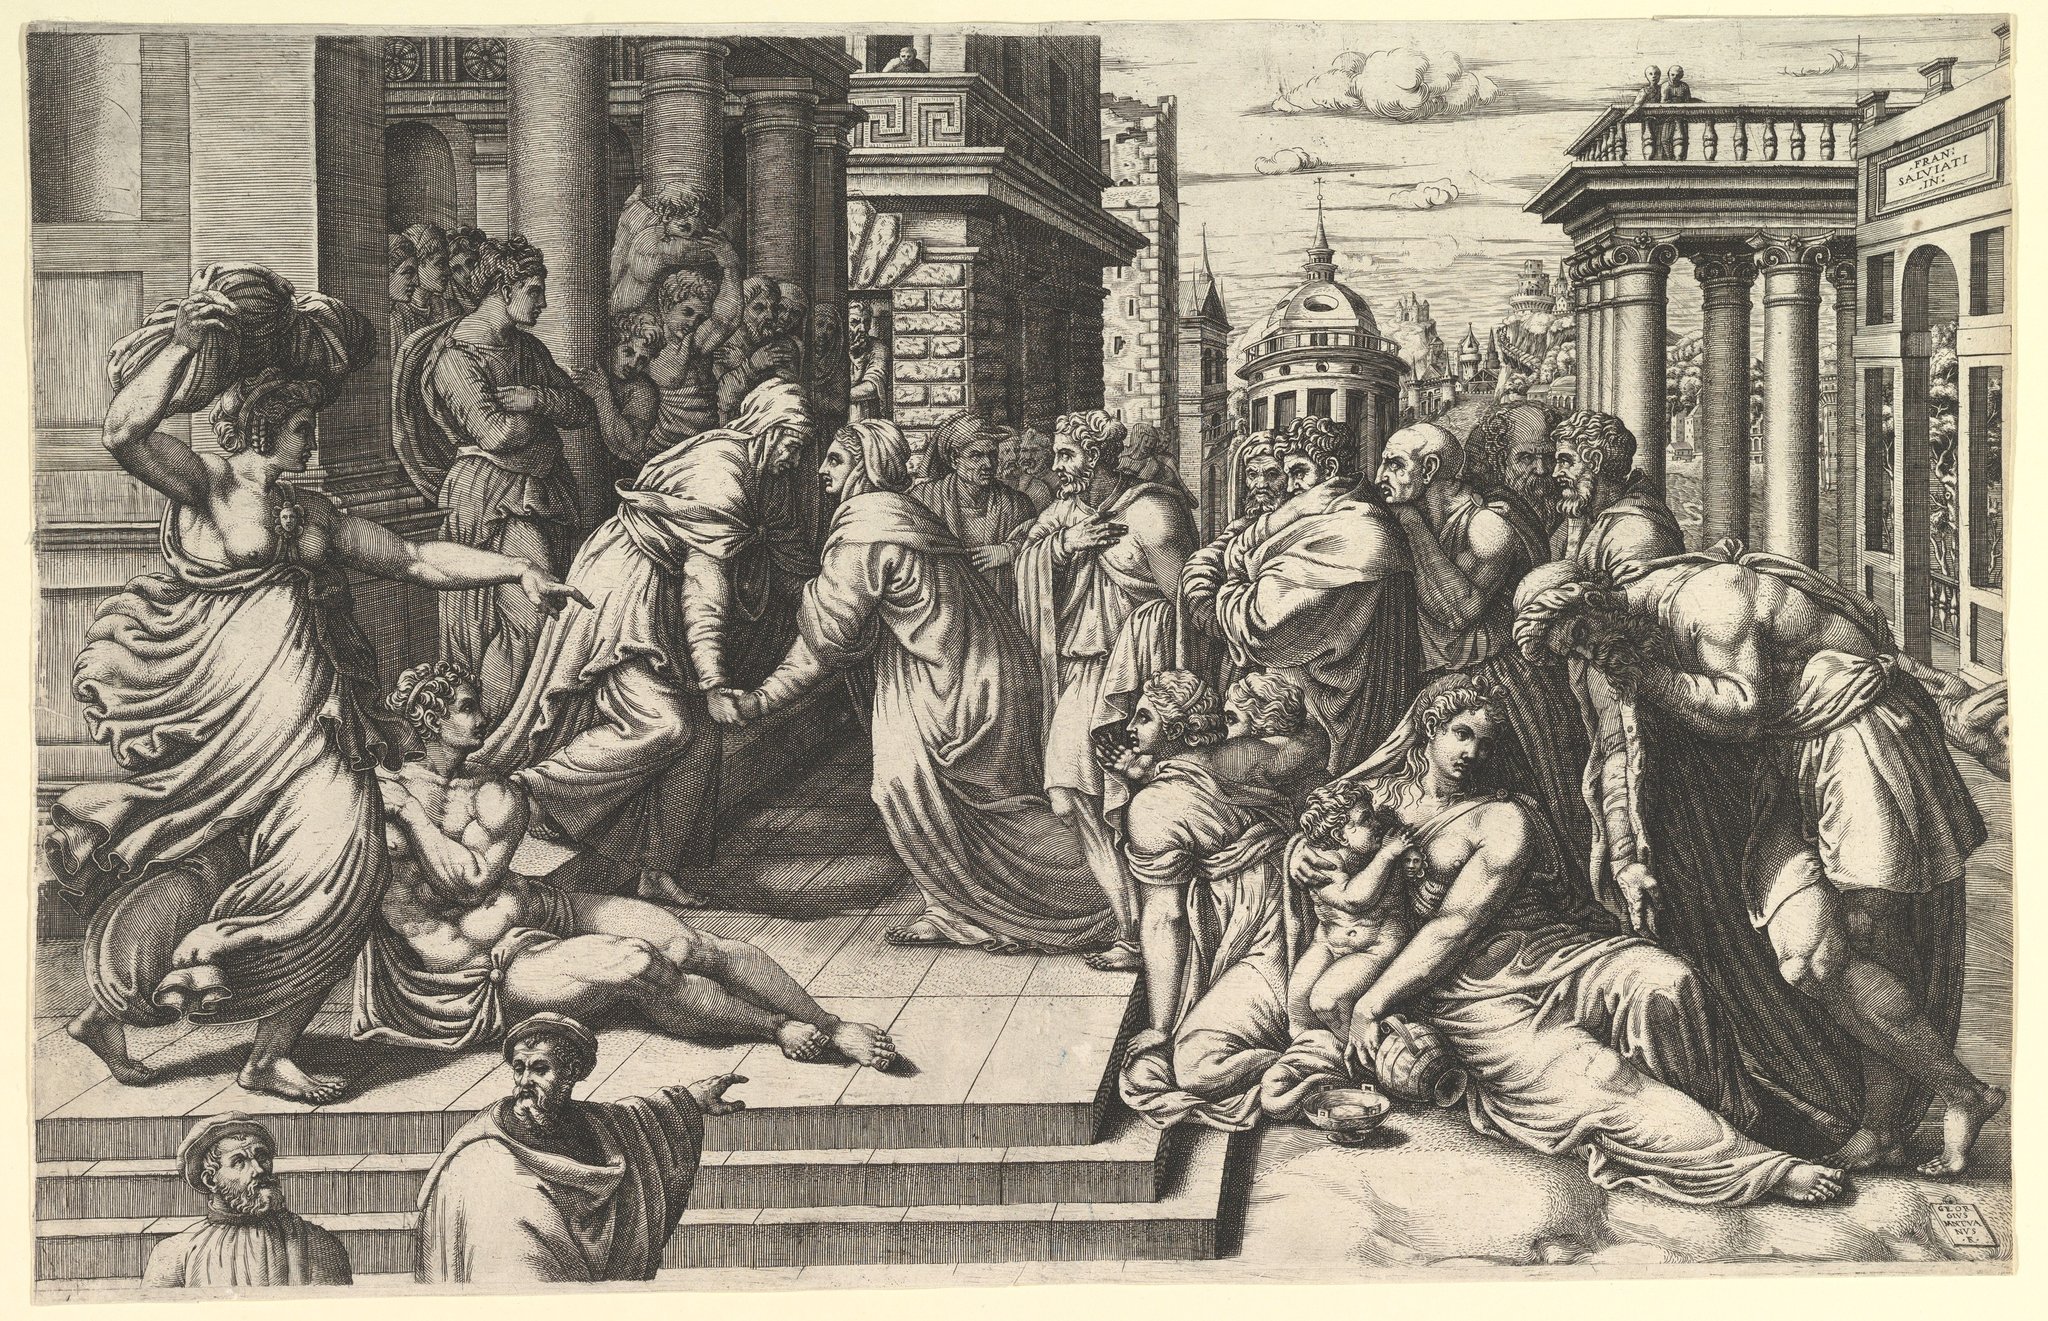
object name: print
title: The Visitation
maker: giorgio ghisi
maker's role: artist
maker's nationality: italian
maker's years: 1515-1582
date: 1540-1550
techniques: engraving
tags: children,men,women,virgin mary